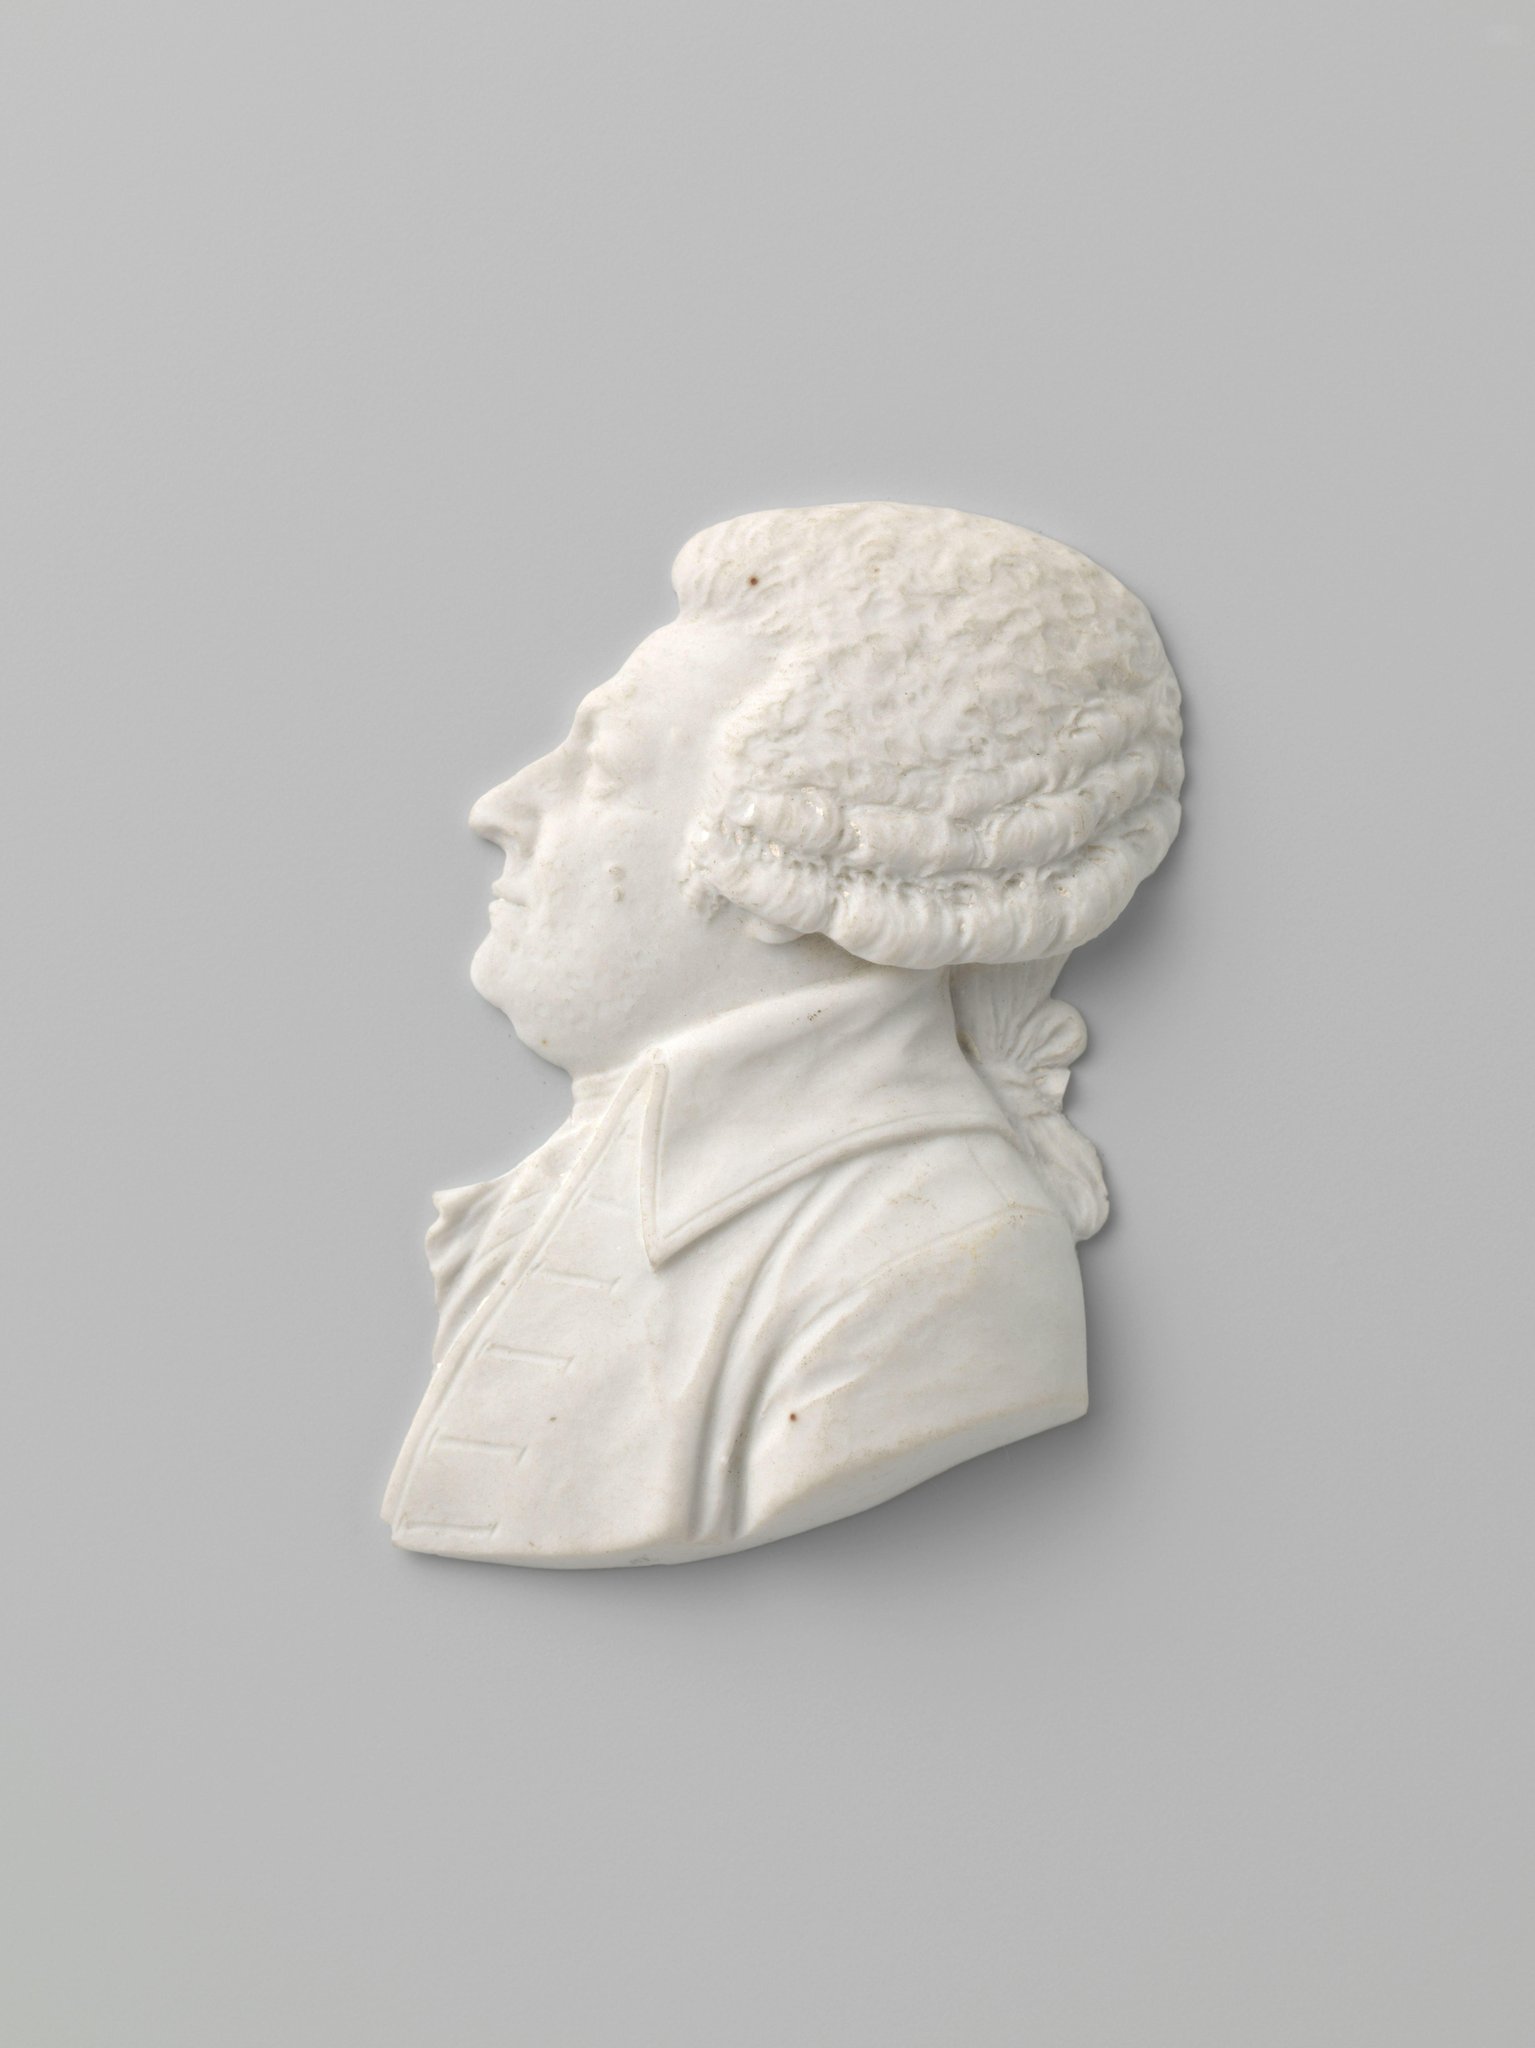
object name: relief sculpture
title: Portrait of the Count of Mirabeau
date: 1780-1795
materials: porcelain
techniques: forming, relief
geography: sèvres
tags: paris, honoré-gabriel de riqueti (graaf van mirabeau)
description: Portret van porselein in biscuit. Het portret toont de Graaf van Mirabeau (1749-1791).